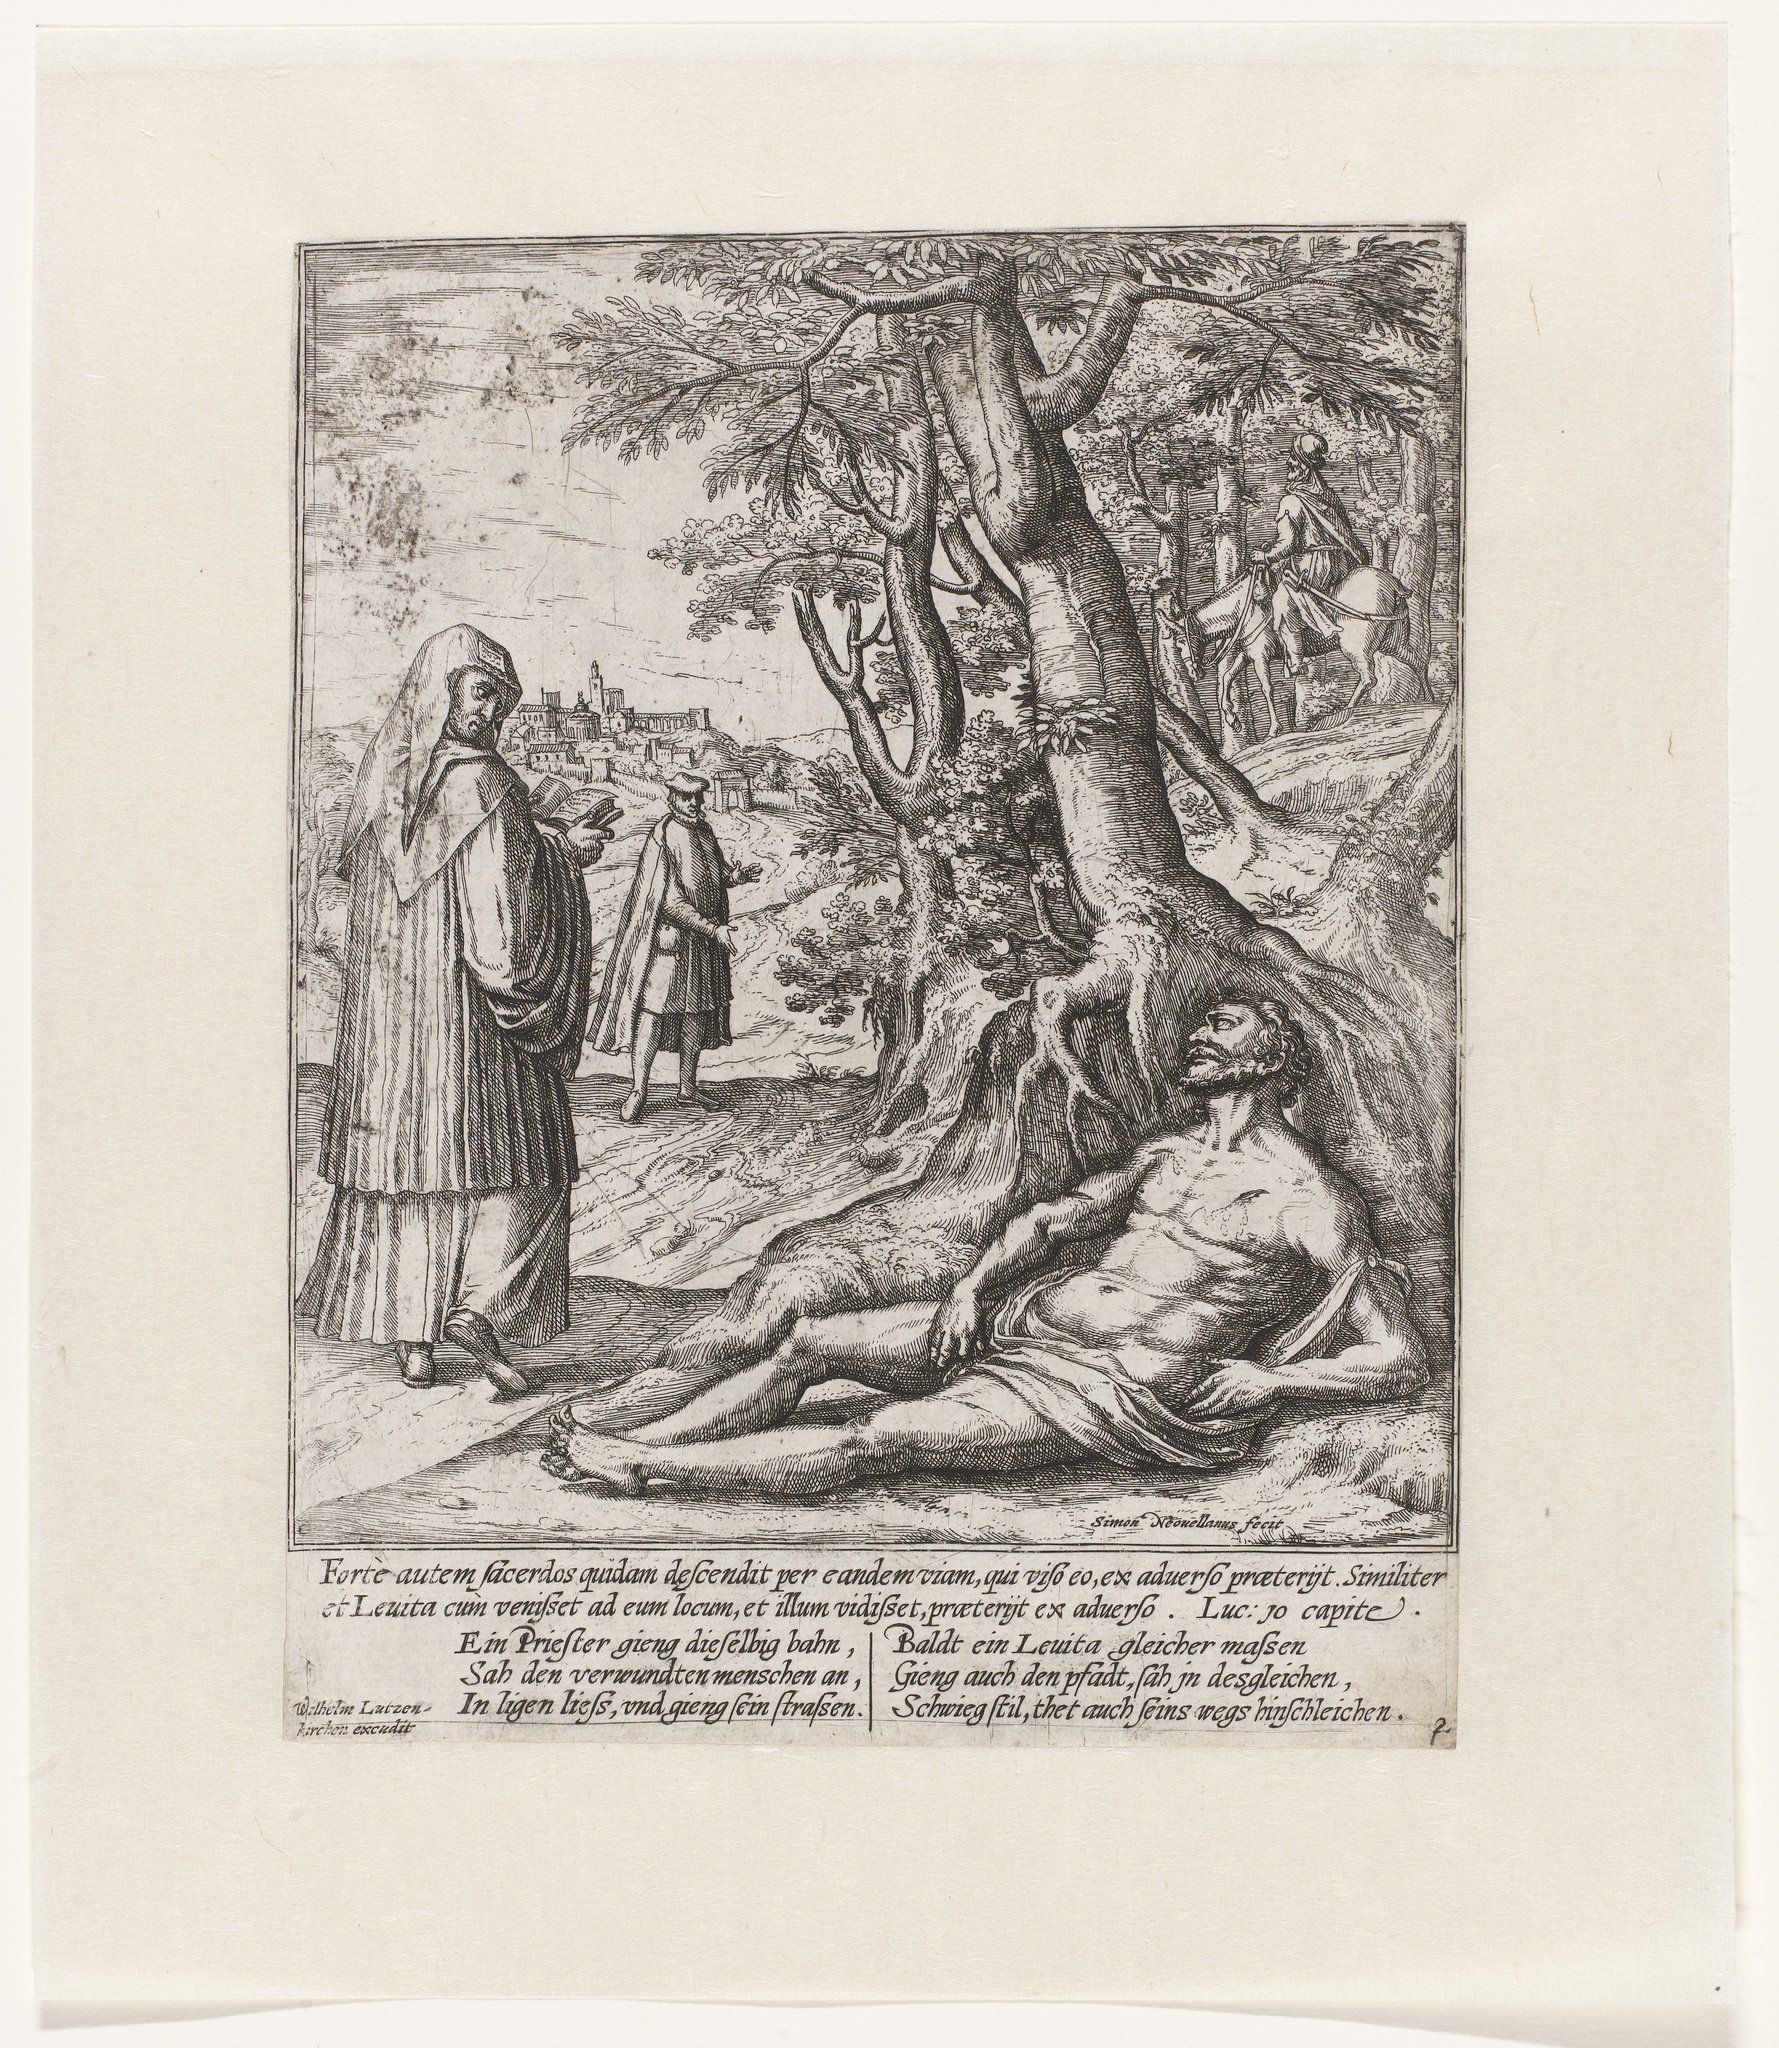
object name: print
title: Een priester en een Leviet gaan voorbij en laten de gewonde reiziger liggen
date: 1560-1590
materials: paper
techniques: etching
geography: cologne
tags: a priest and/or a levite passing by without attending to the wounded man ~ parable of the good samaritan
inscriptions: collector's mark: Lugt 2228, collector's mark: Lugt 2760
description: De priester en de Leviet lopen over een bospad en kijken naar de gewonde naakte reiziger die aan de kant van het pad ligt. Ze bieden geen hulp. Vanuit het bos nadert de barmhartige Samaritaan op een ezel. In de verte een stad. Onder de afbeelding een tweeregelige tekst in het Latijn uit Luc. 10 en een zesregelig vers in het Duits.